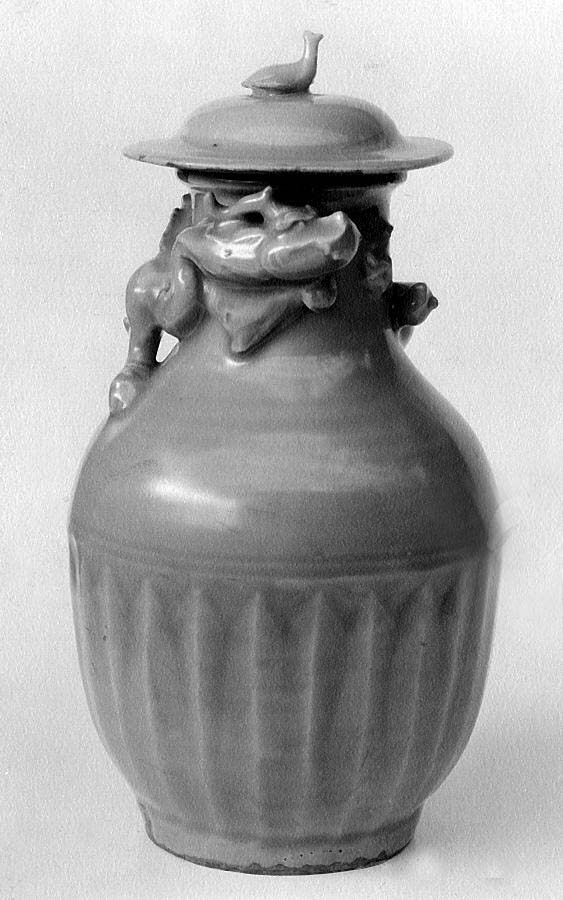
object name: covered jar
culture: chinese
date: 1101-1300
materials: ceramic glaze, glaze